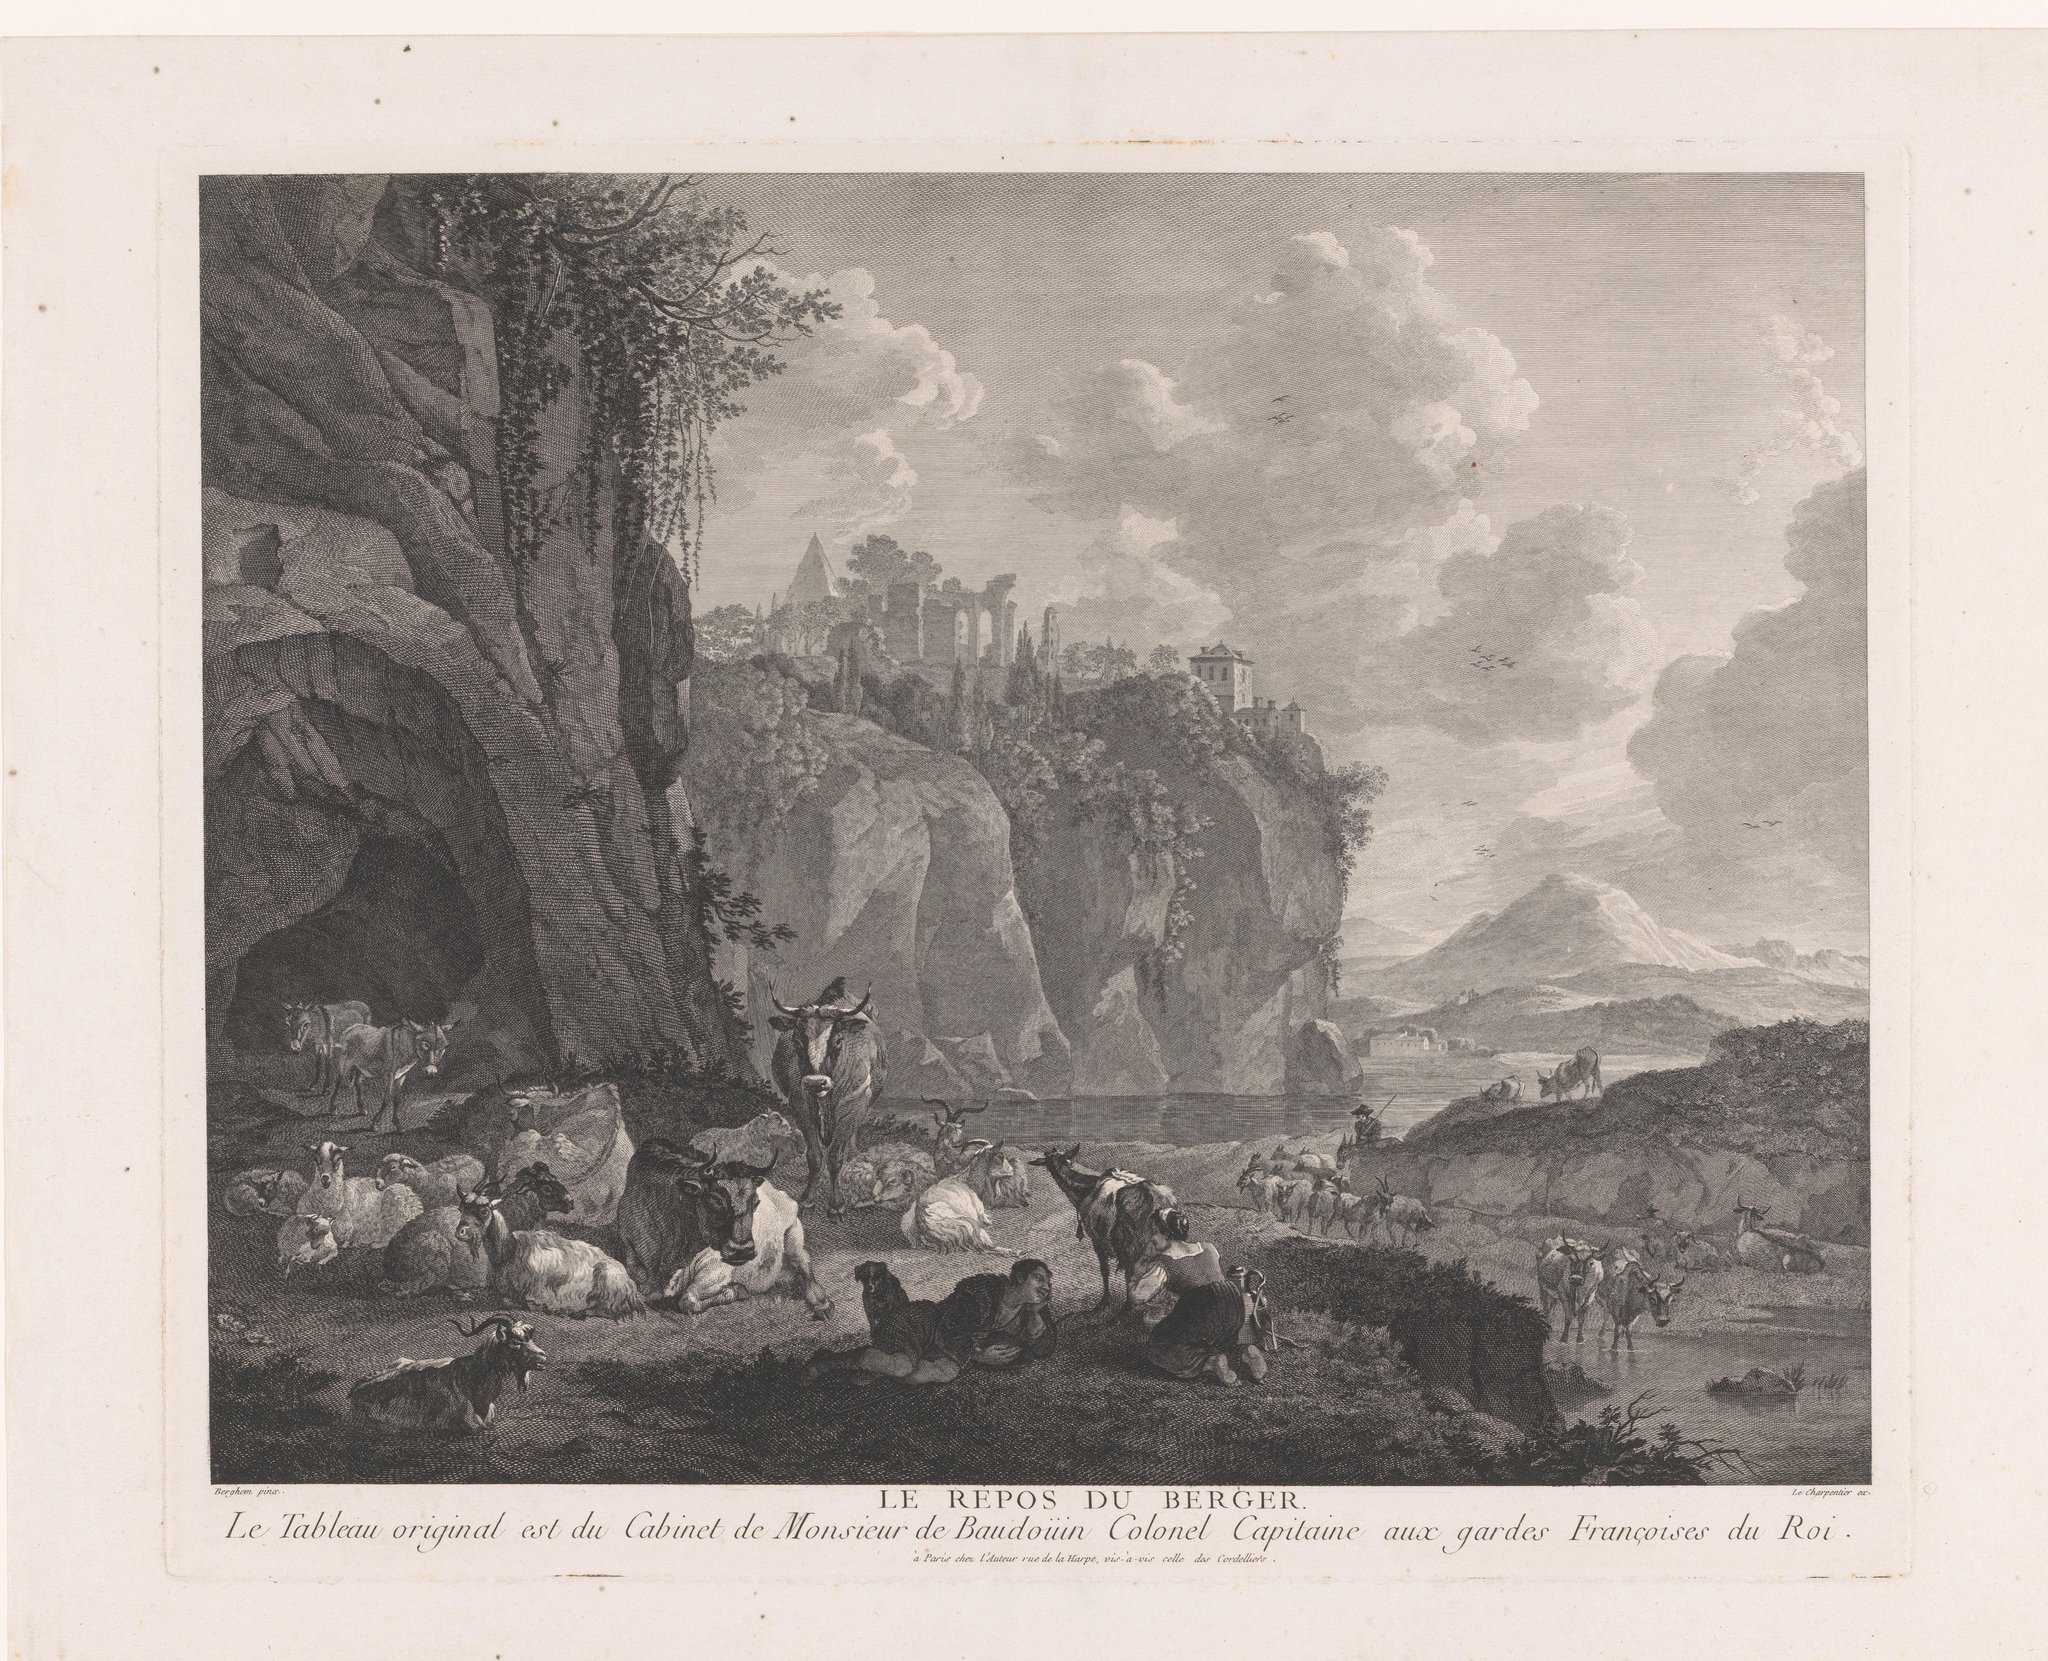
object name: print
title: Le Repos du Berger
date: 1743-1770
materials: paper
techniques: engraving, etching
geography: paris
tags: giving water, feeding (cattle), herd, flock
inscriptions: inscription: ‘f220,,16’, collector's mark: Lugt 240